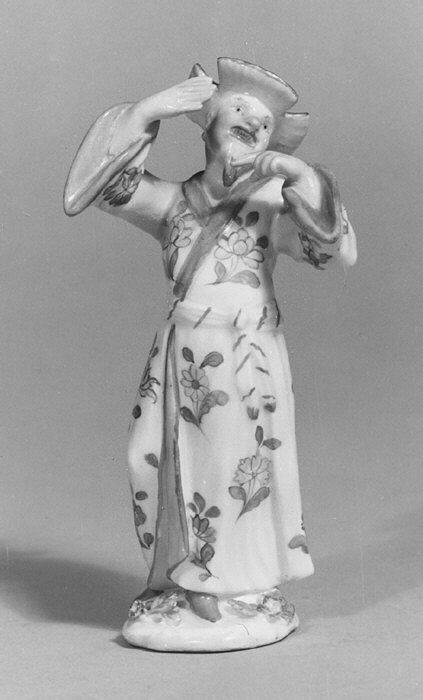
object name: figure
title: Chinese man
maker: meissen manufactory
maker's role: manufactory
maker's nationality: german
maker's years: 1710-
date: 1745-1750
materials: hard paste porcelain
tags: men,flowers